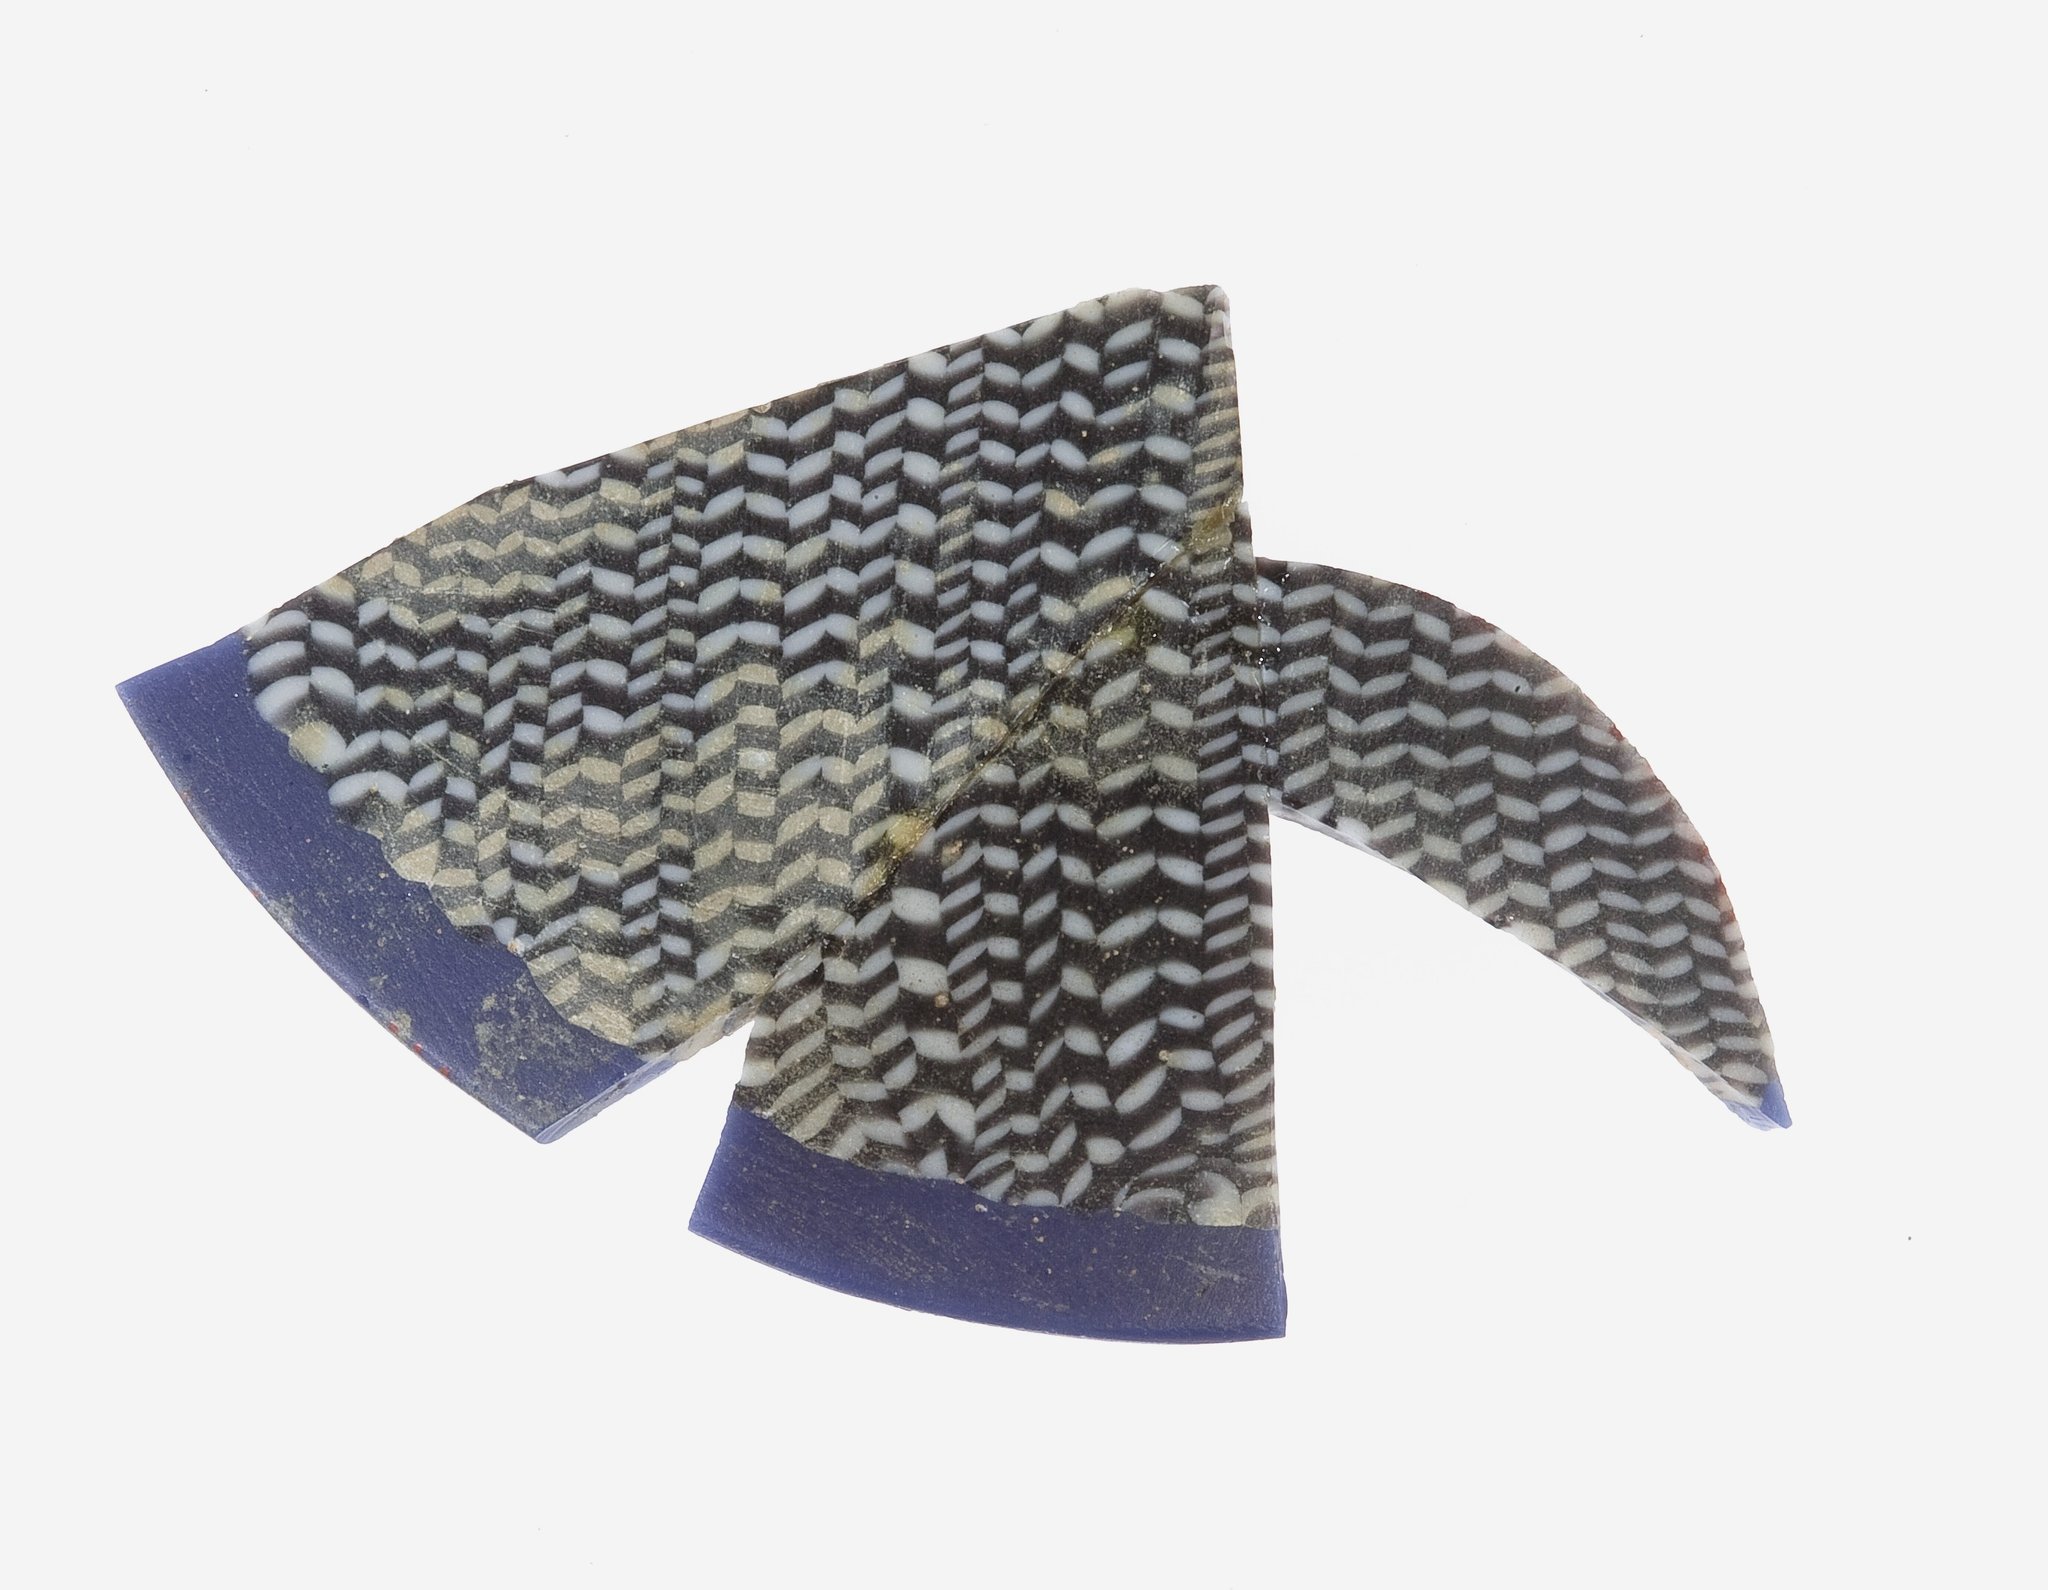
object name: dish fragment, joined with 26. 7. 1236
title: Fragments of a Dish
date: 1390-1352 BCE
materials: glass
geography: egypt